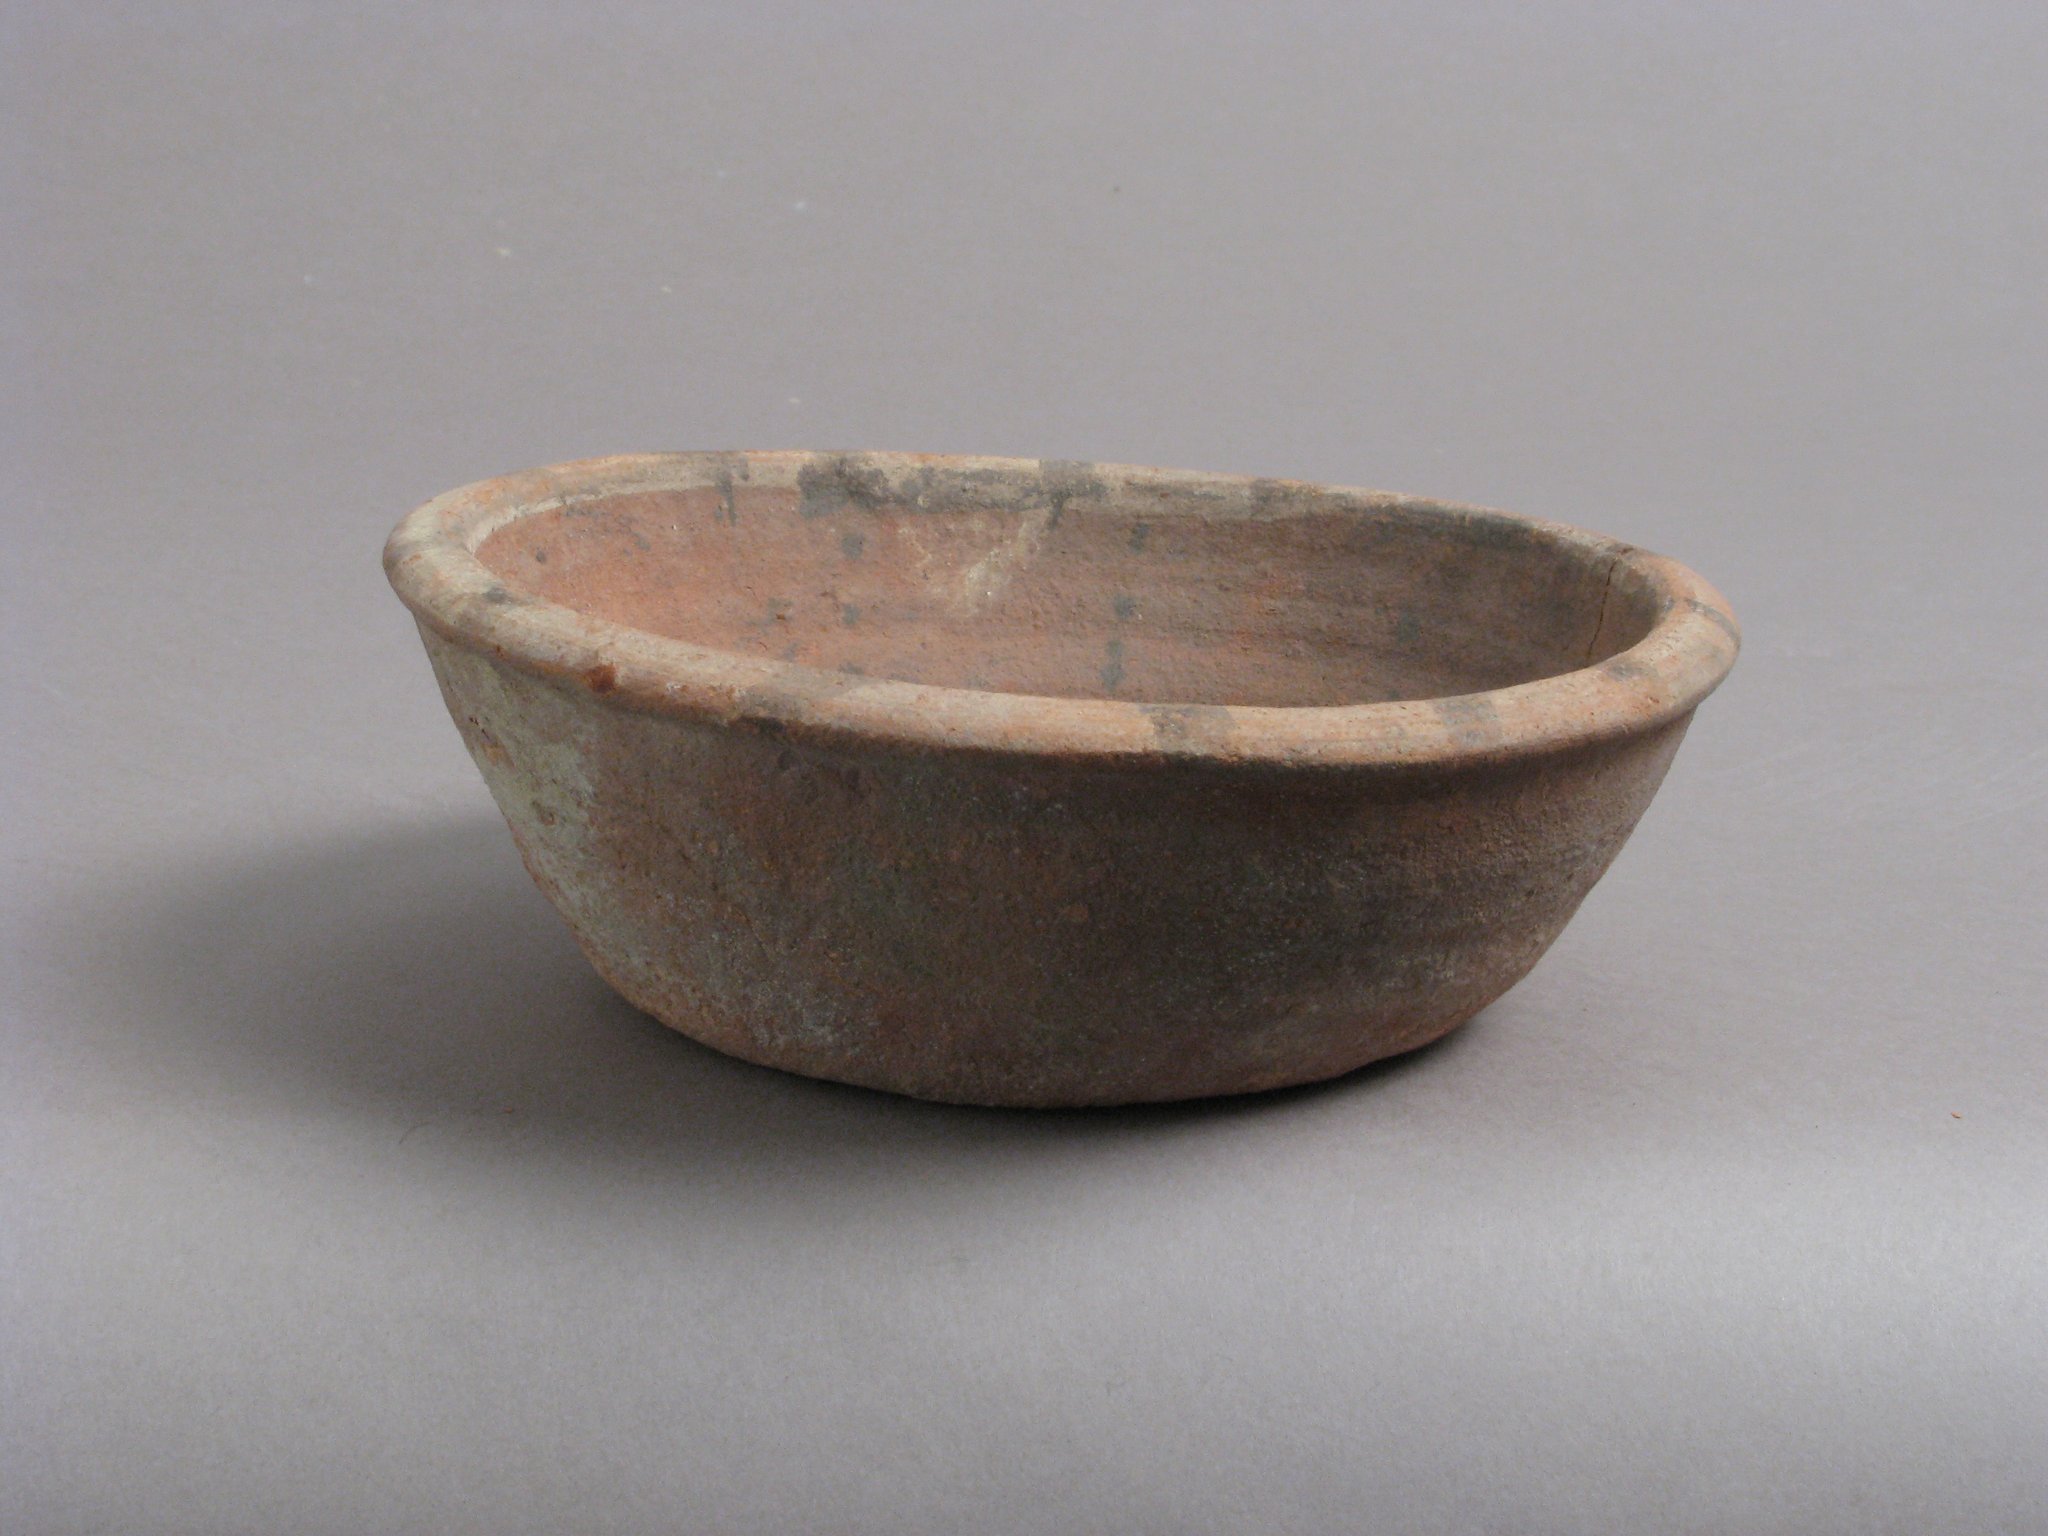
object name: bowl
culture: coptic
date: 301-700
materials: earthenware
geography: egypt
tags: bowls